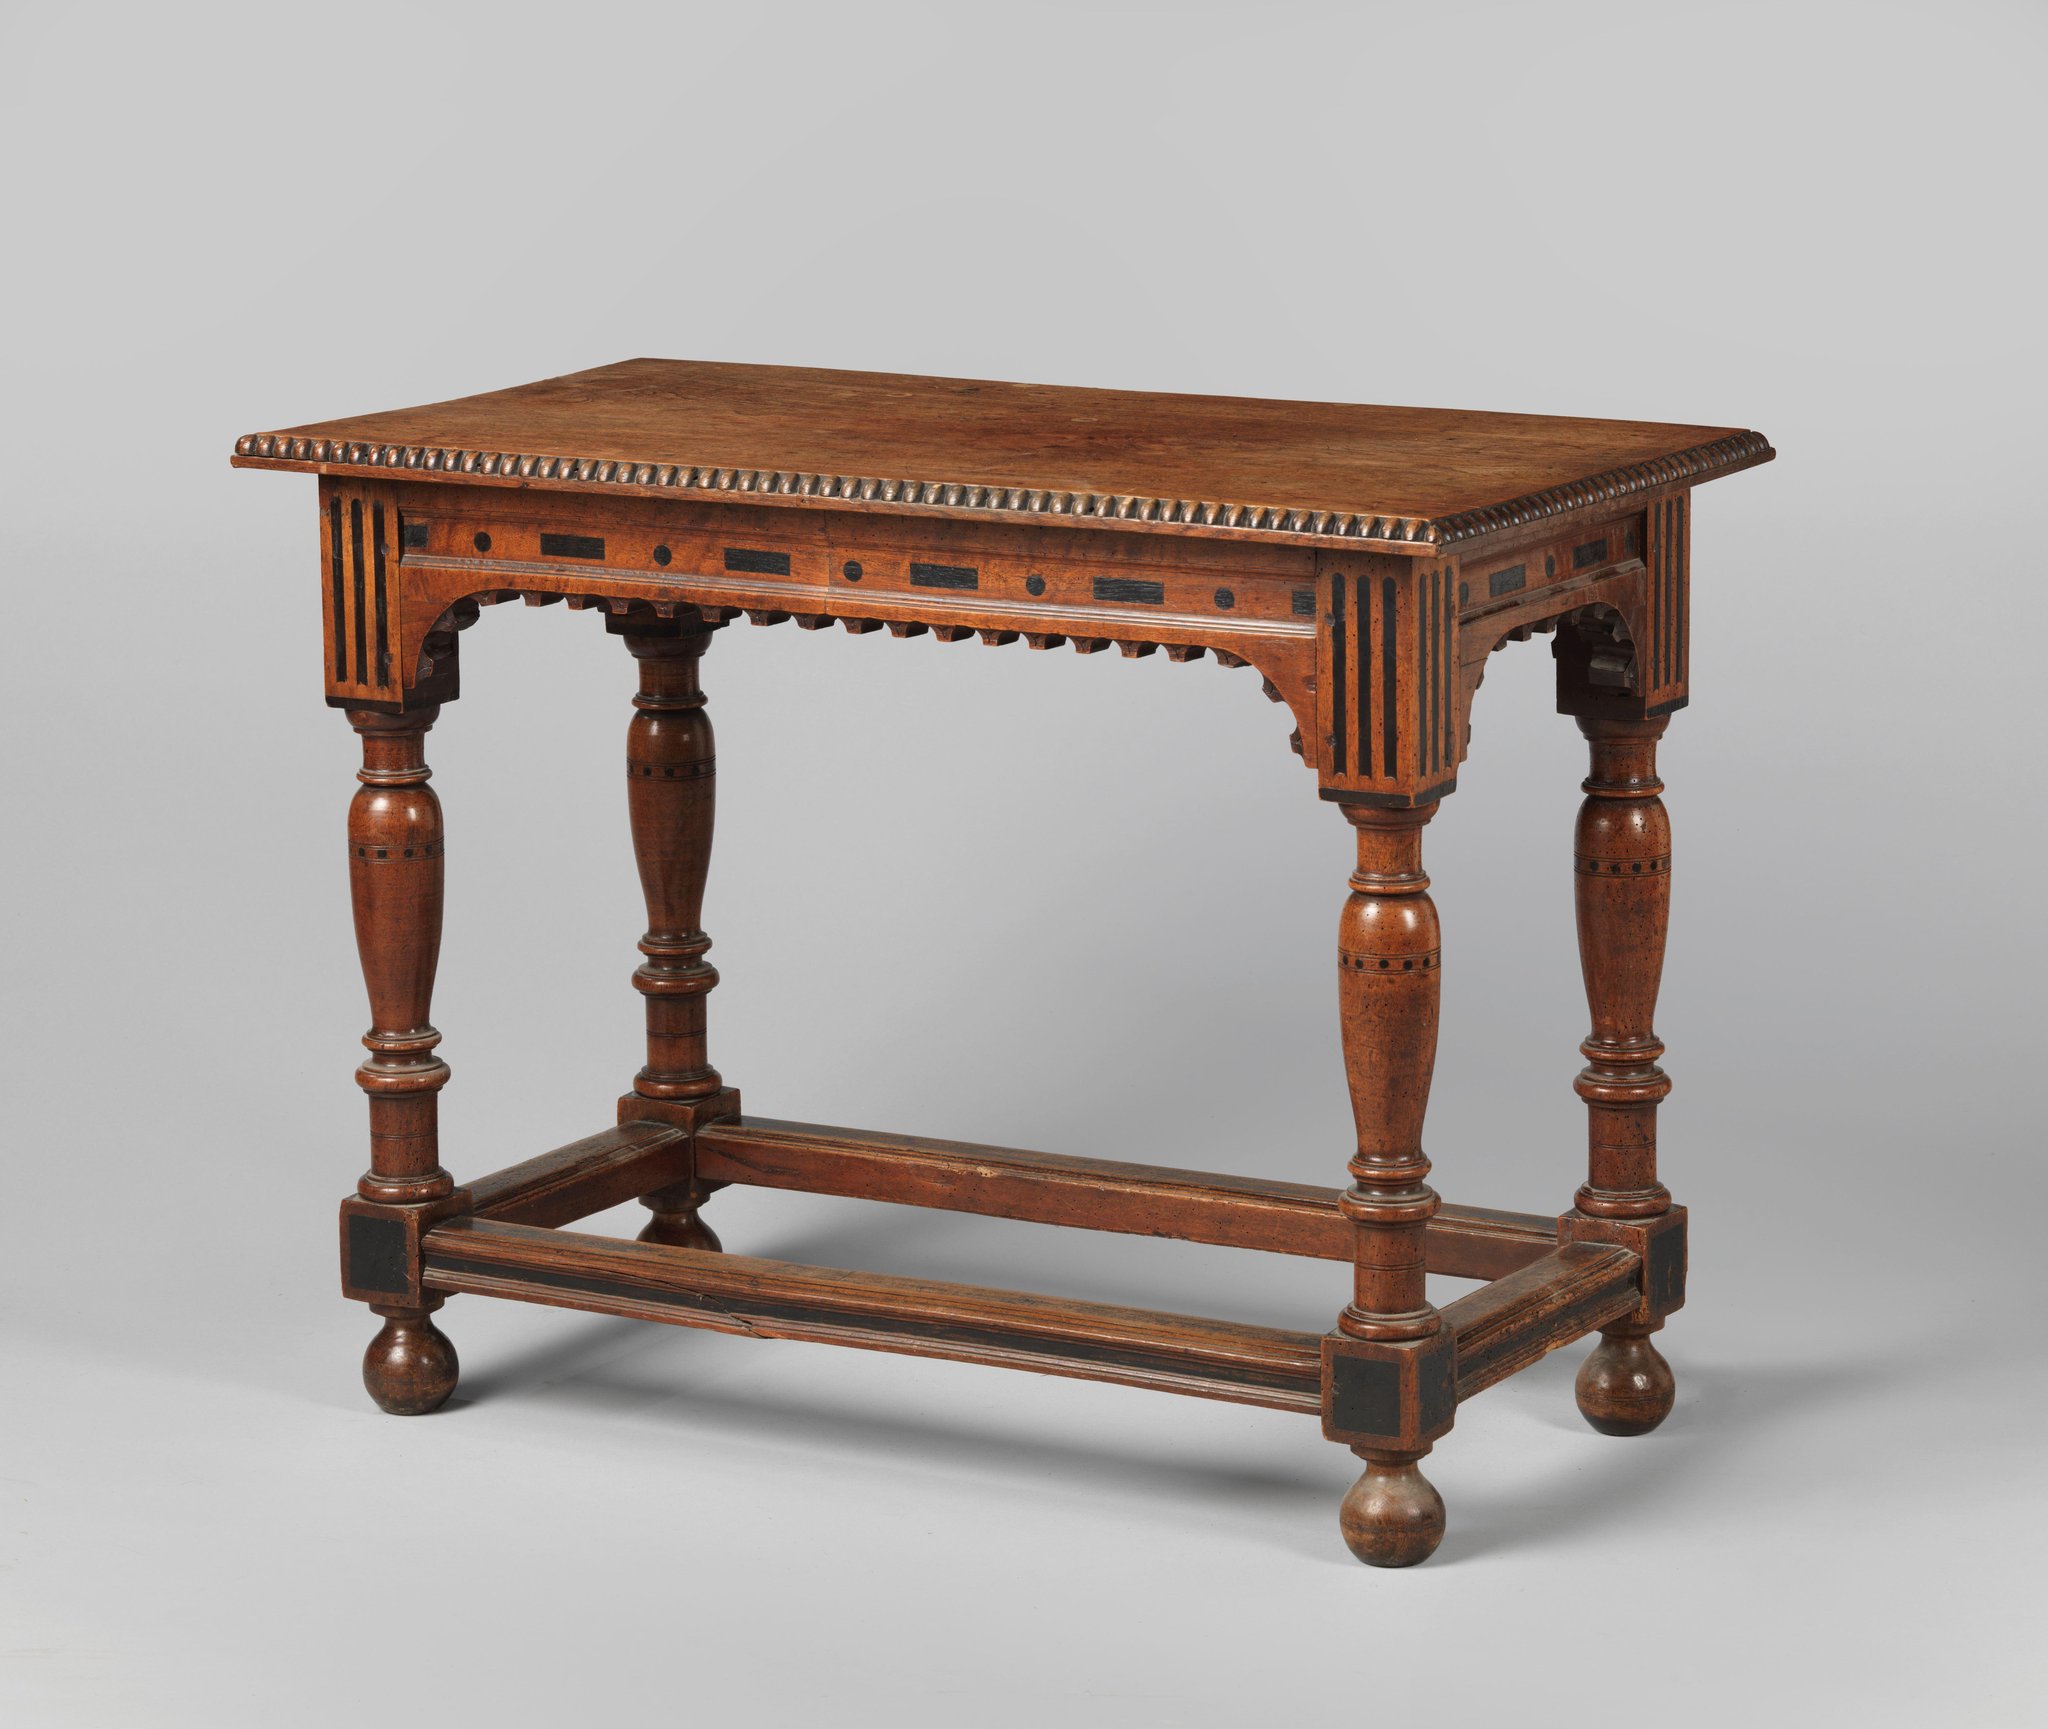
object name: table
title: Tafel met vaasvormige poten, verbonden door onderregels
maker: Anonymous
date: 1640-1660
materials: wood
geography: netherlands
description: Tafel van notenhout op poten met vaasvormige geledingen en huizen en verbonden door onderregels. De bovenregel heeft een geholde tandlijst, die met ronde steunstukken meeloopt. De regels zijn uitgegrond en evenals de huizen en de zwellingen der poten versierd met cannelures en banden van ebbenhout. Het blad heeft een kraallijst.